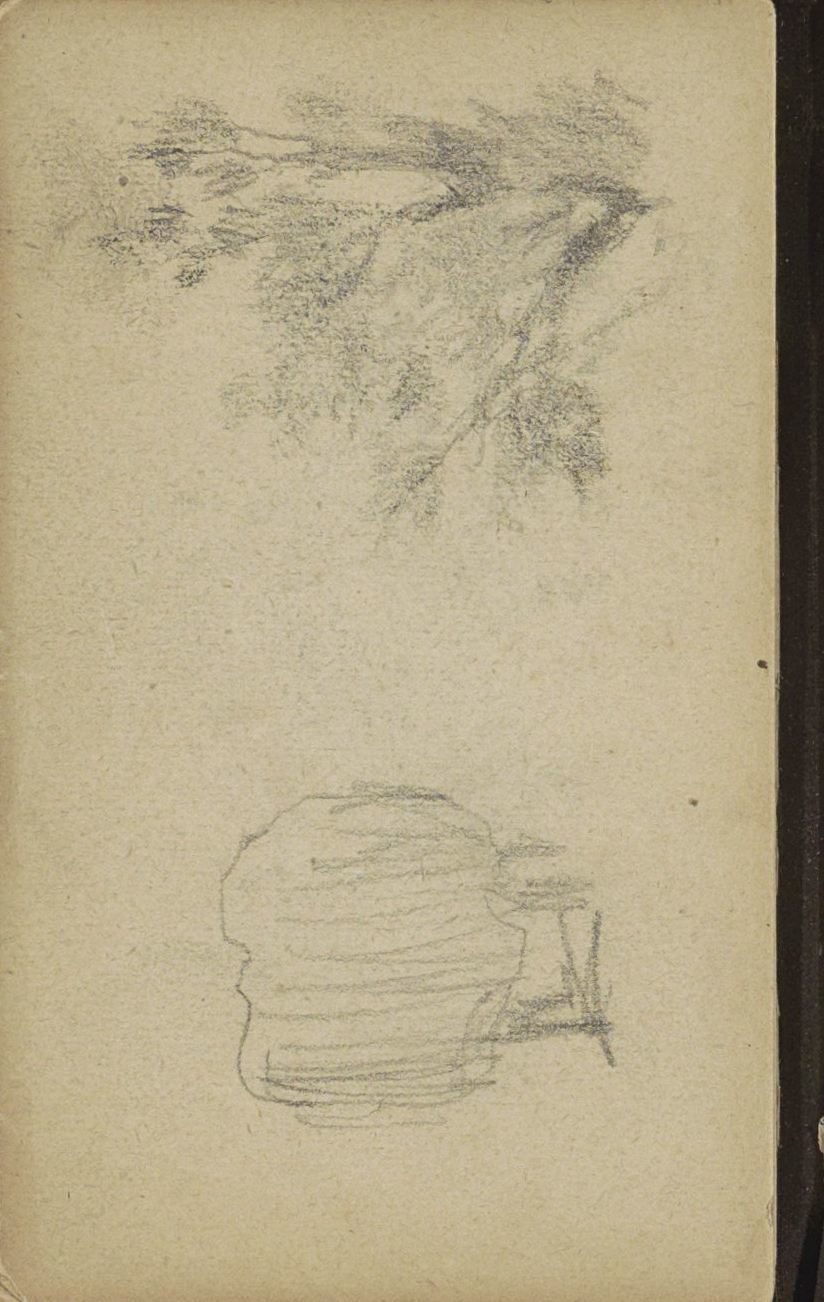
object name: sketchbook leaf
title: Bomen en boomtoppen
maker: johan hendrik weissenbruch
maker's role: draughtsman, painter, print maker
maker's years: 1824-1903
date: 1834-1903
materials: paper, pencil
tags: trees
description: Blad 15 verso uit een schetsboek met 32 bladen.